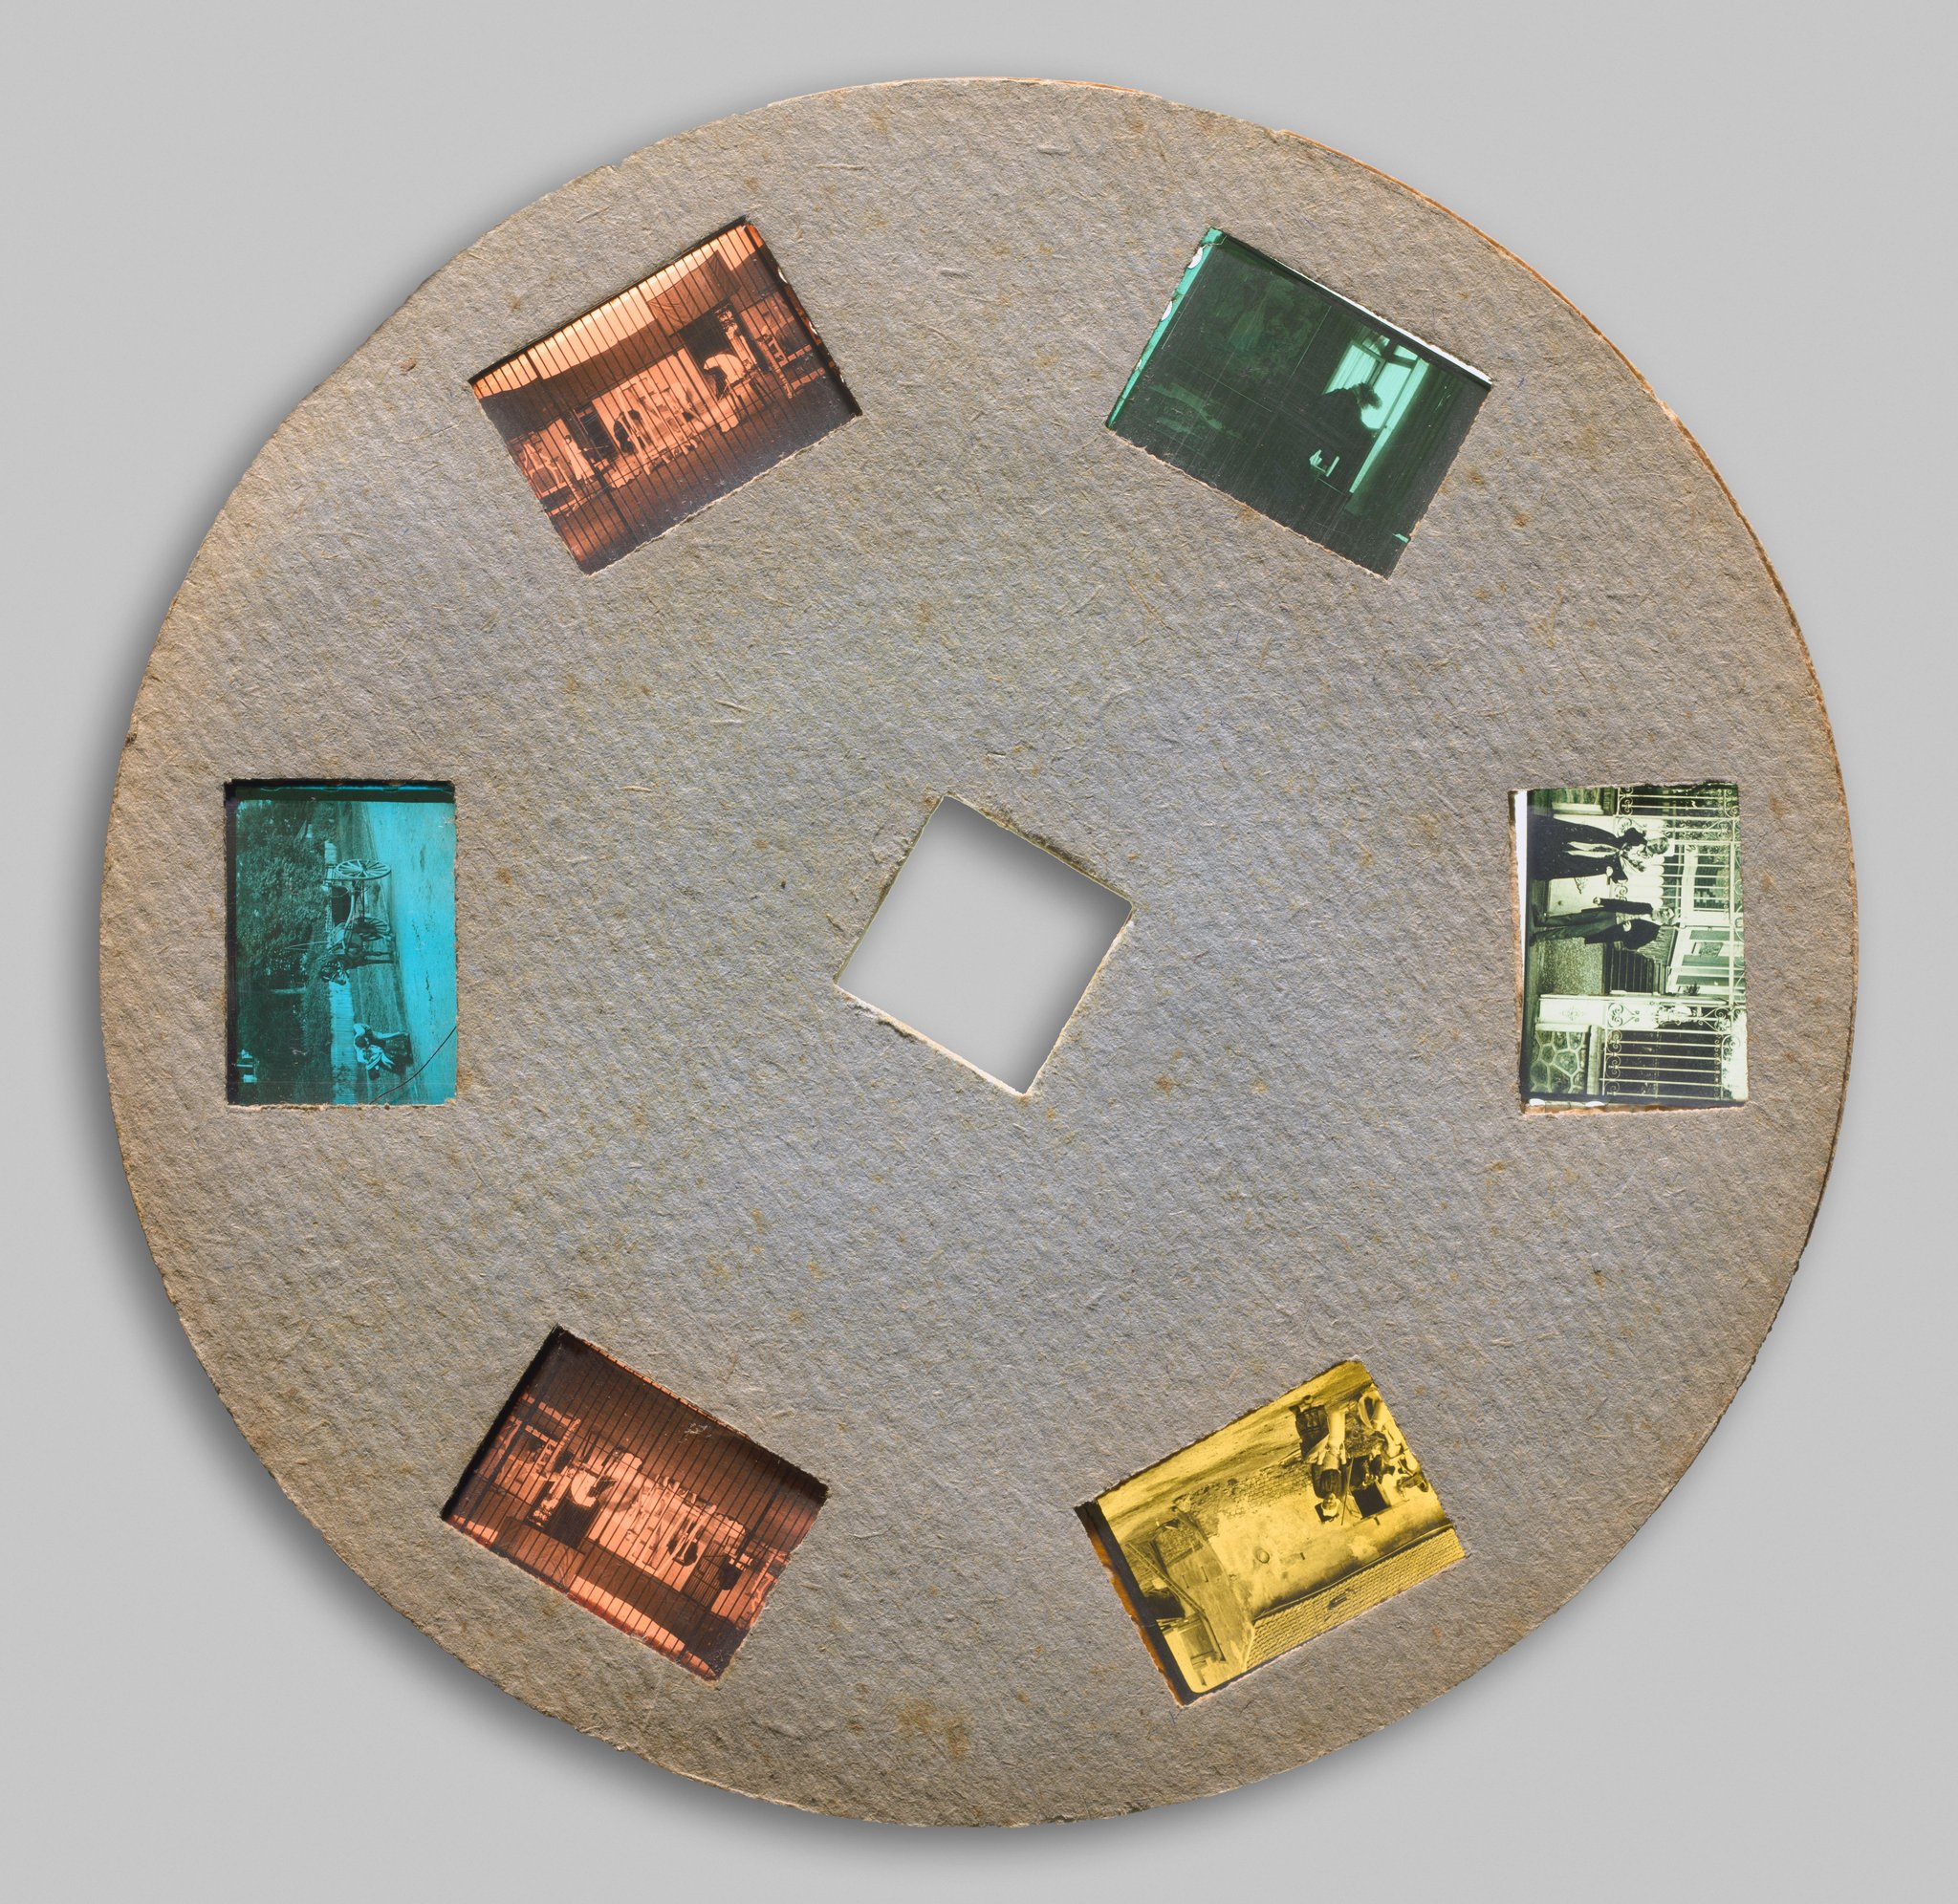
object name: lantern slide photographic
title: Zes lantaarnplaatjes met verschillende filmscènes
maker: Anonymous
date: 1910-1930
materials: cardboard, film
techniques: colour, gelatin silver transparency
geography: czechoslovakia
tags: actors on the screen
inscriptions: number: ‘5’, inscription: ‘TRADE MARKE/ MEISSNA/ KINO/ E.J.M.P./ D.R.G.M. HUNGAR PATENT’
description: Zes lantaarnplaatjes met filmscènes, ingeraamd in een ronde kartonnen schijf.